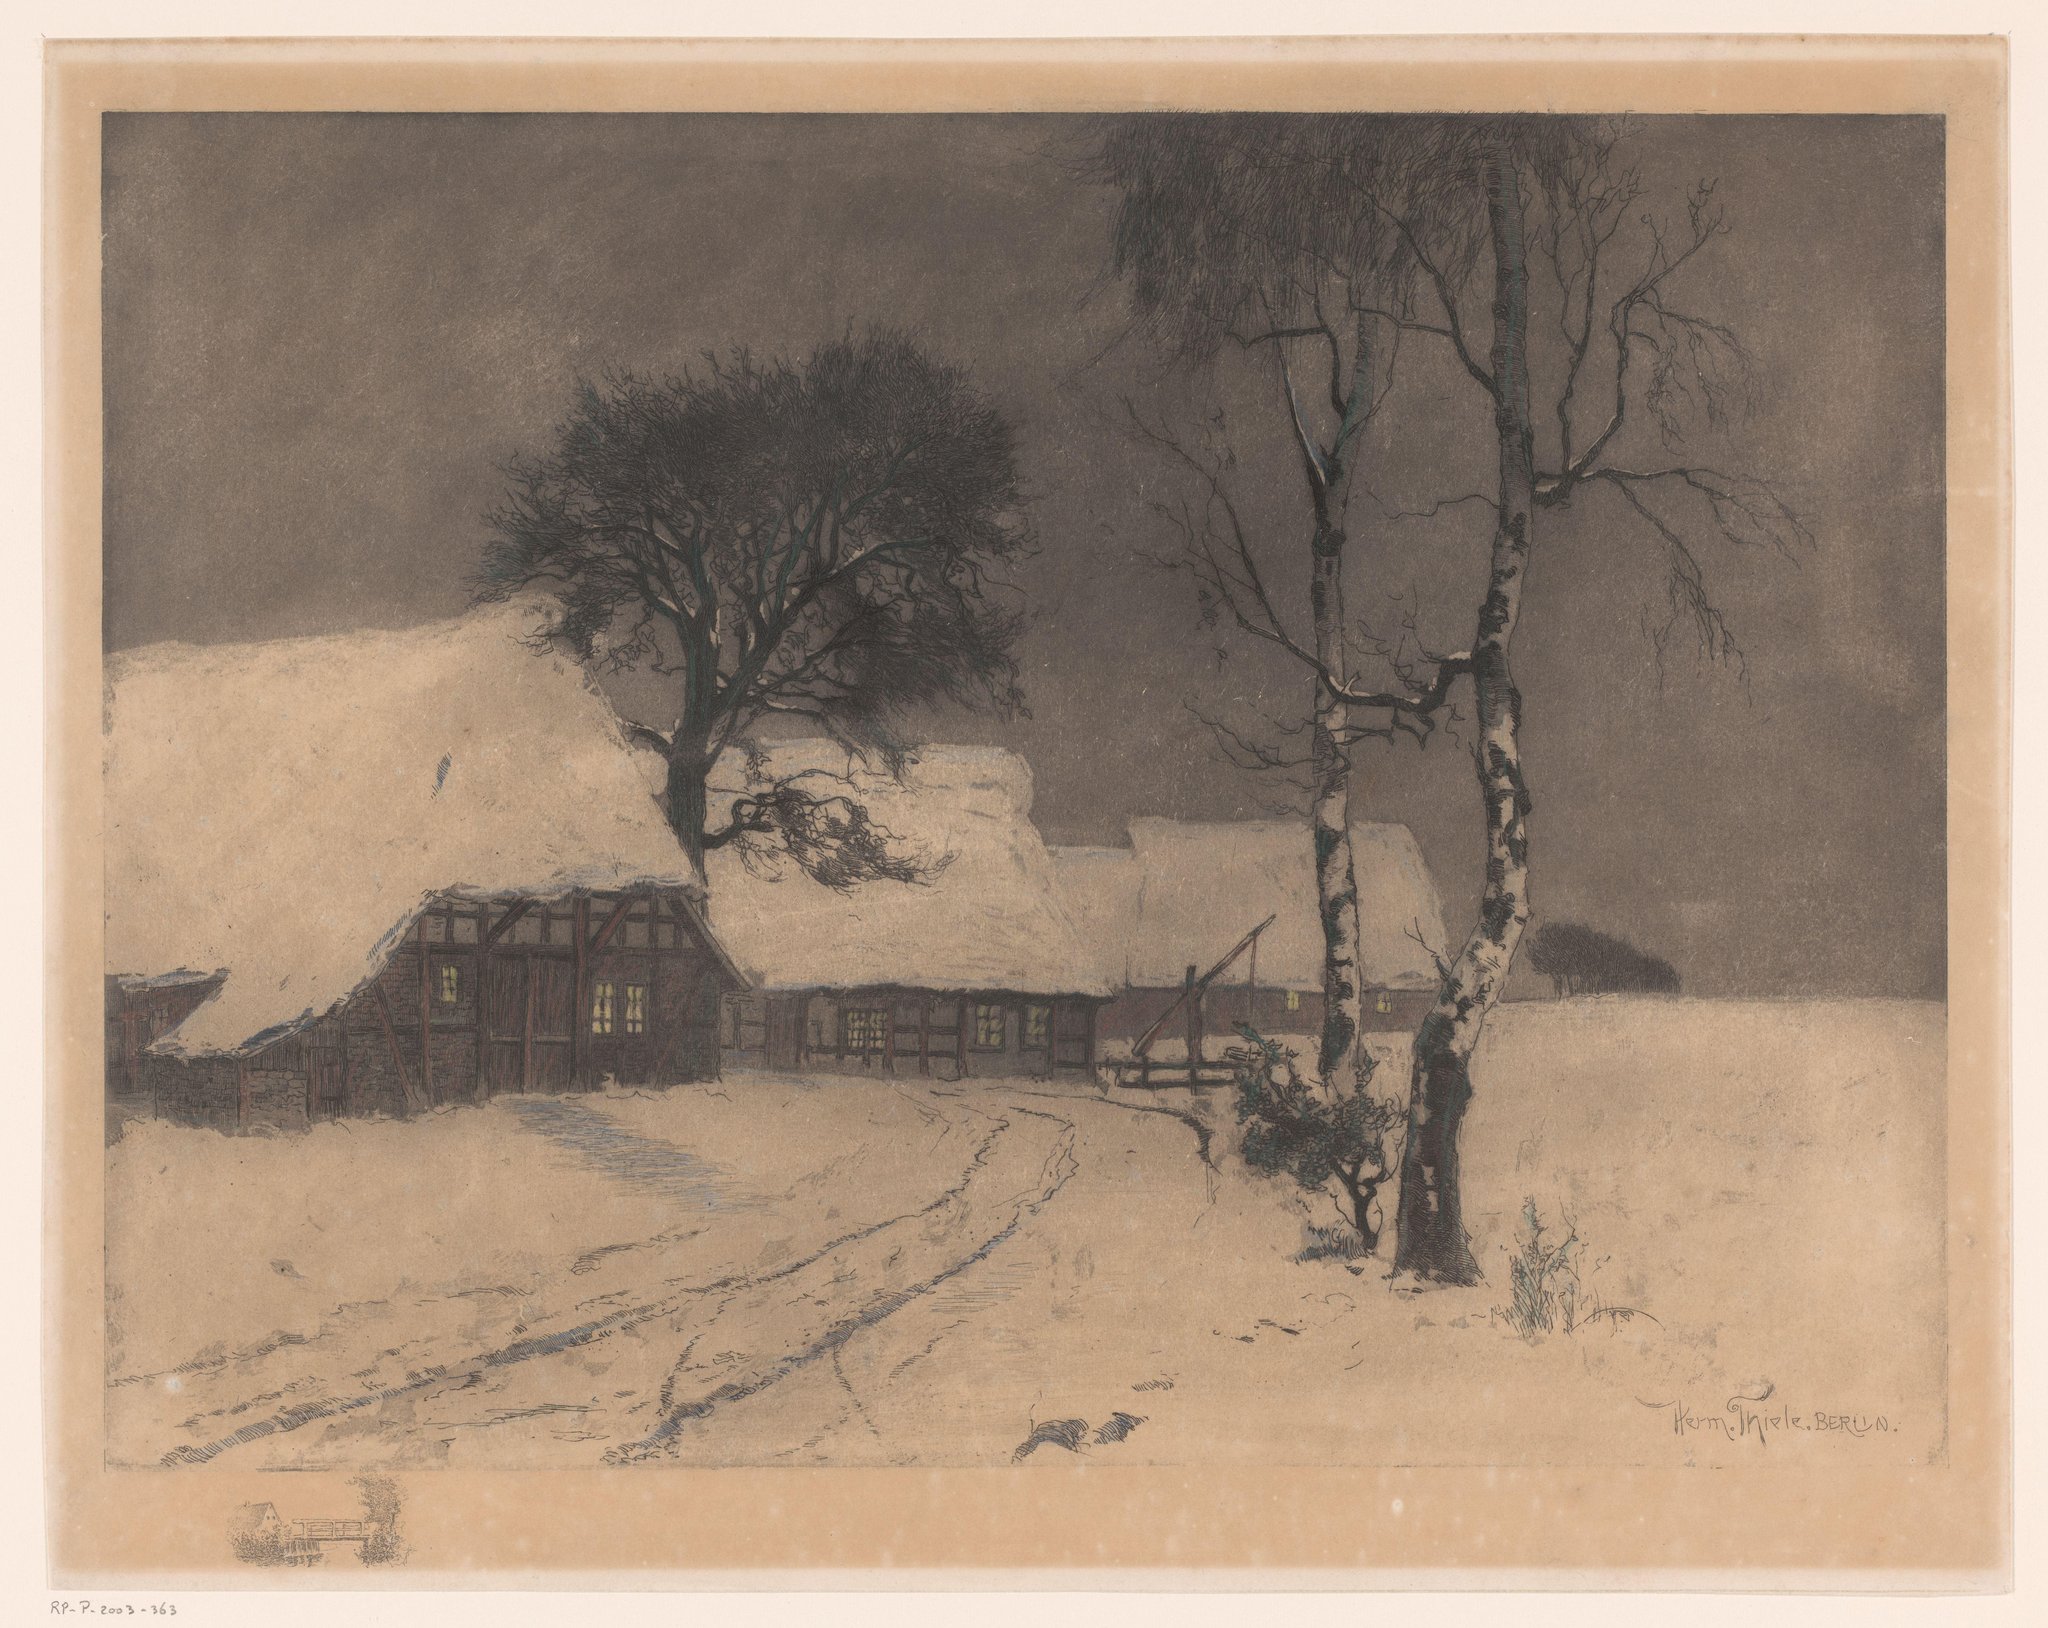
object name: print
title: Boerenwoningen in de sneeuw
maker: hermann thiele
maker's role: painter, print maker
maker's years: 1867-1939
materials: chalk, paper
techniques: etching, intaglio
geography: berlin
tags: snow, farm (building)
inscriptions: collector's mark: Lugt 2228